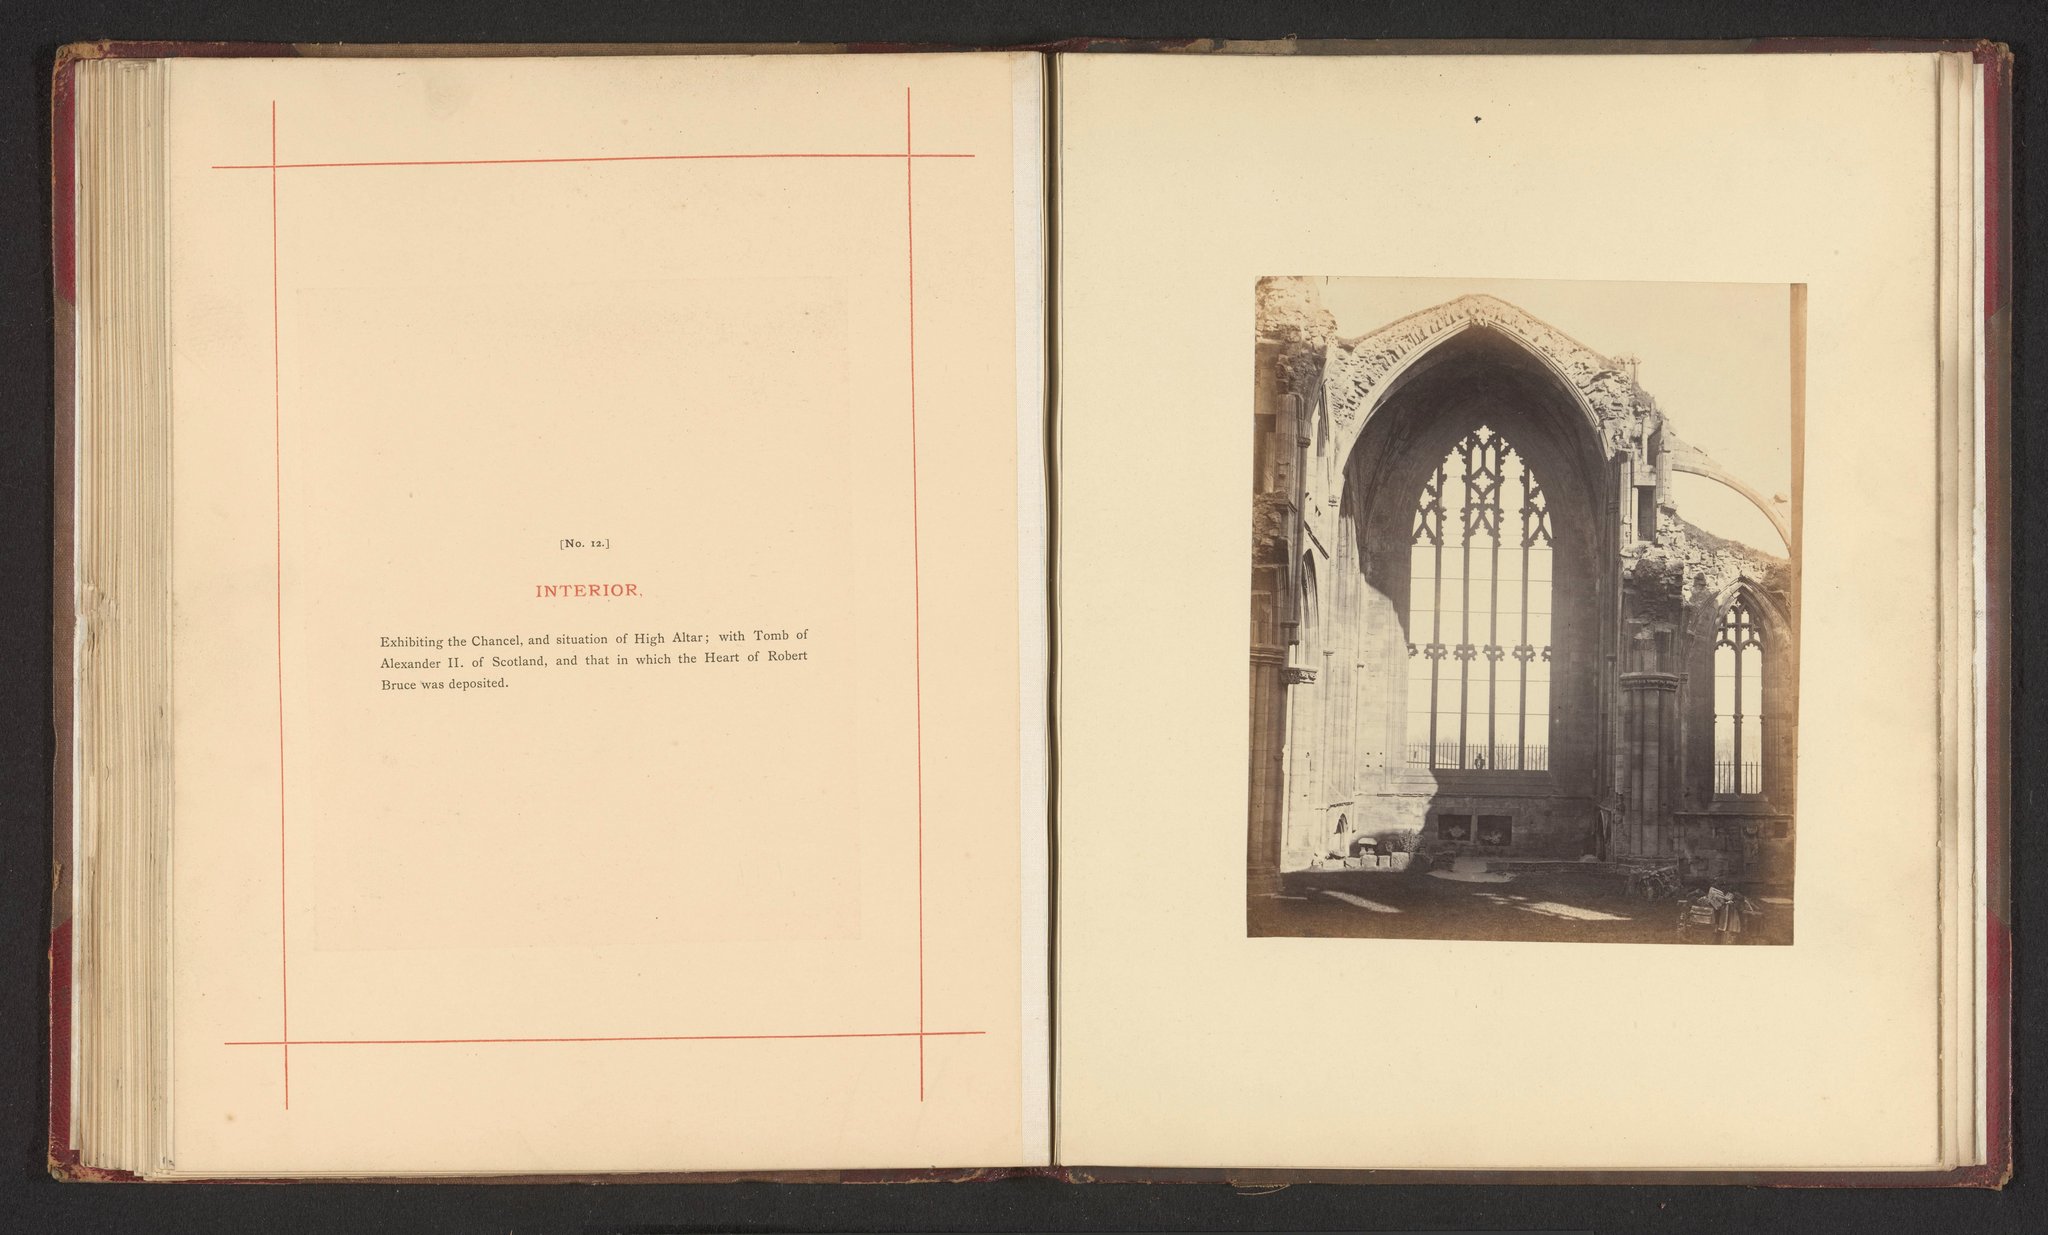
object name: page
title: Gezicht op een raam van de ruïne van Melrose Abbey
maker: w.j. pringle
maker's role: fotograaf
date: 1860-1870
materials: photographic support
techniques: albumen print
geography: melrose abbey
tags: church-window, e.g. rose-window, ruin of church, monastery, etc.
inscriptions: number: ‘(No. 12.)’, inscription: ‘Exhibiting the Chancel, and situation of High Altar; with Tomb of Alexander II. of Scotland, and that in wich the Heart of Robert Bruce was deposited.’, title: ‘Interior’